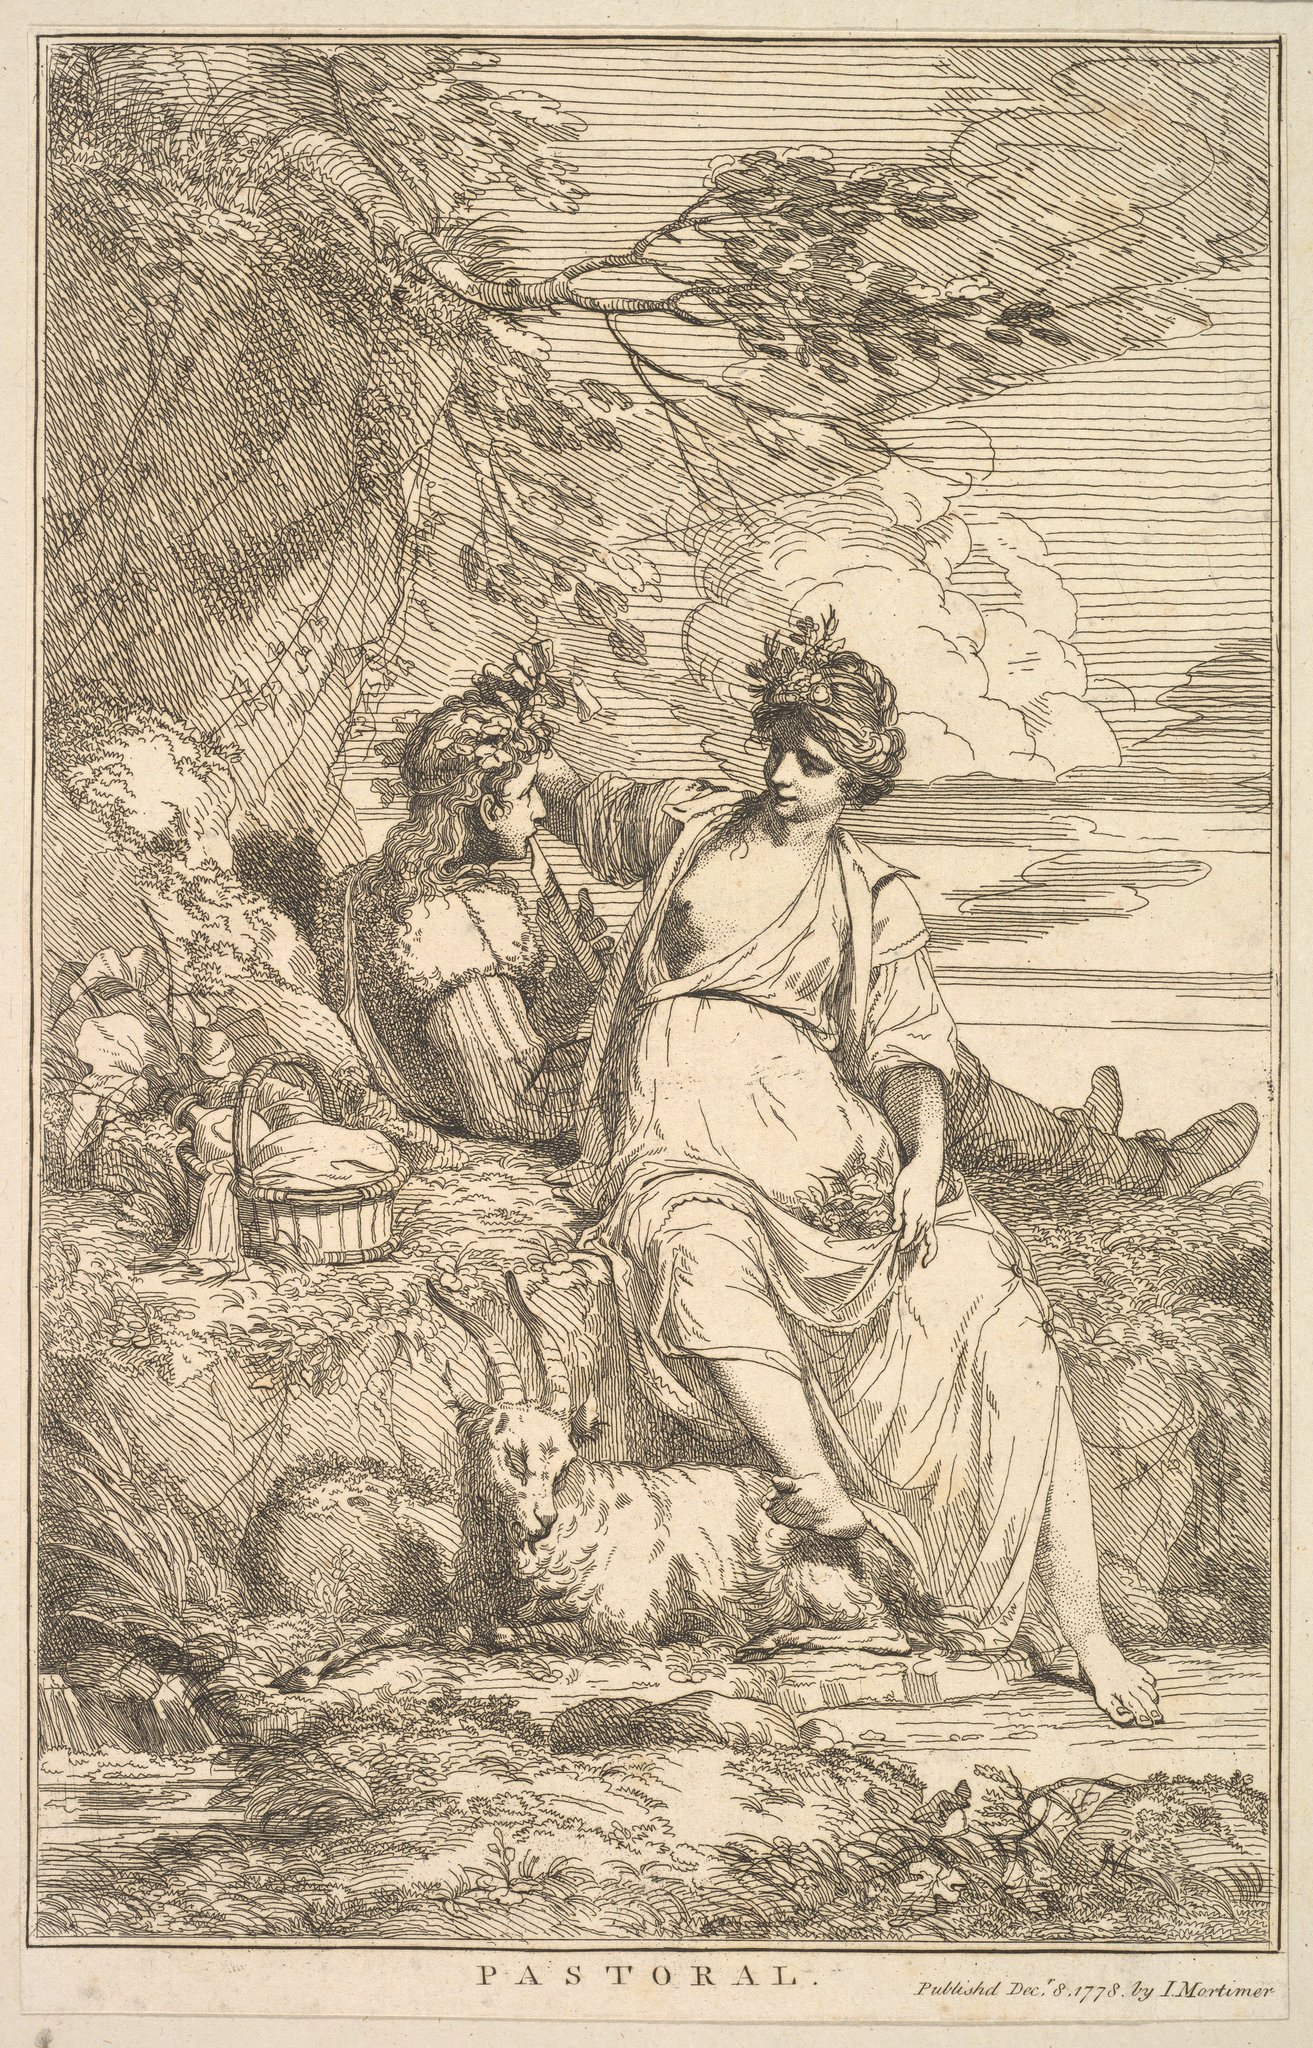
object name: print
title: Pastoral, from "Fifteen Etchings Dedicated to Sir Joshua Reynolds"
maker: john hamilton mortimer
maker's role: artist and publisher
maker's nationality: british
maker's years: 1740-1779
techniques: etching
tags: animals,men,women,pastoral,trees